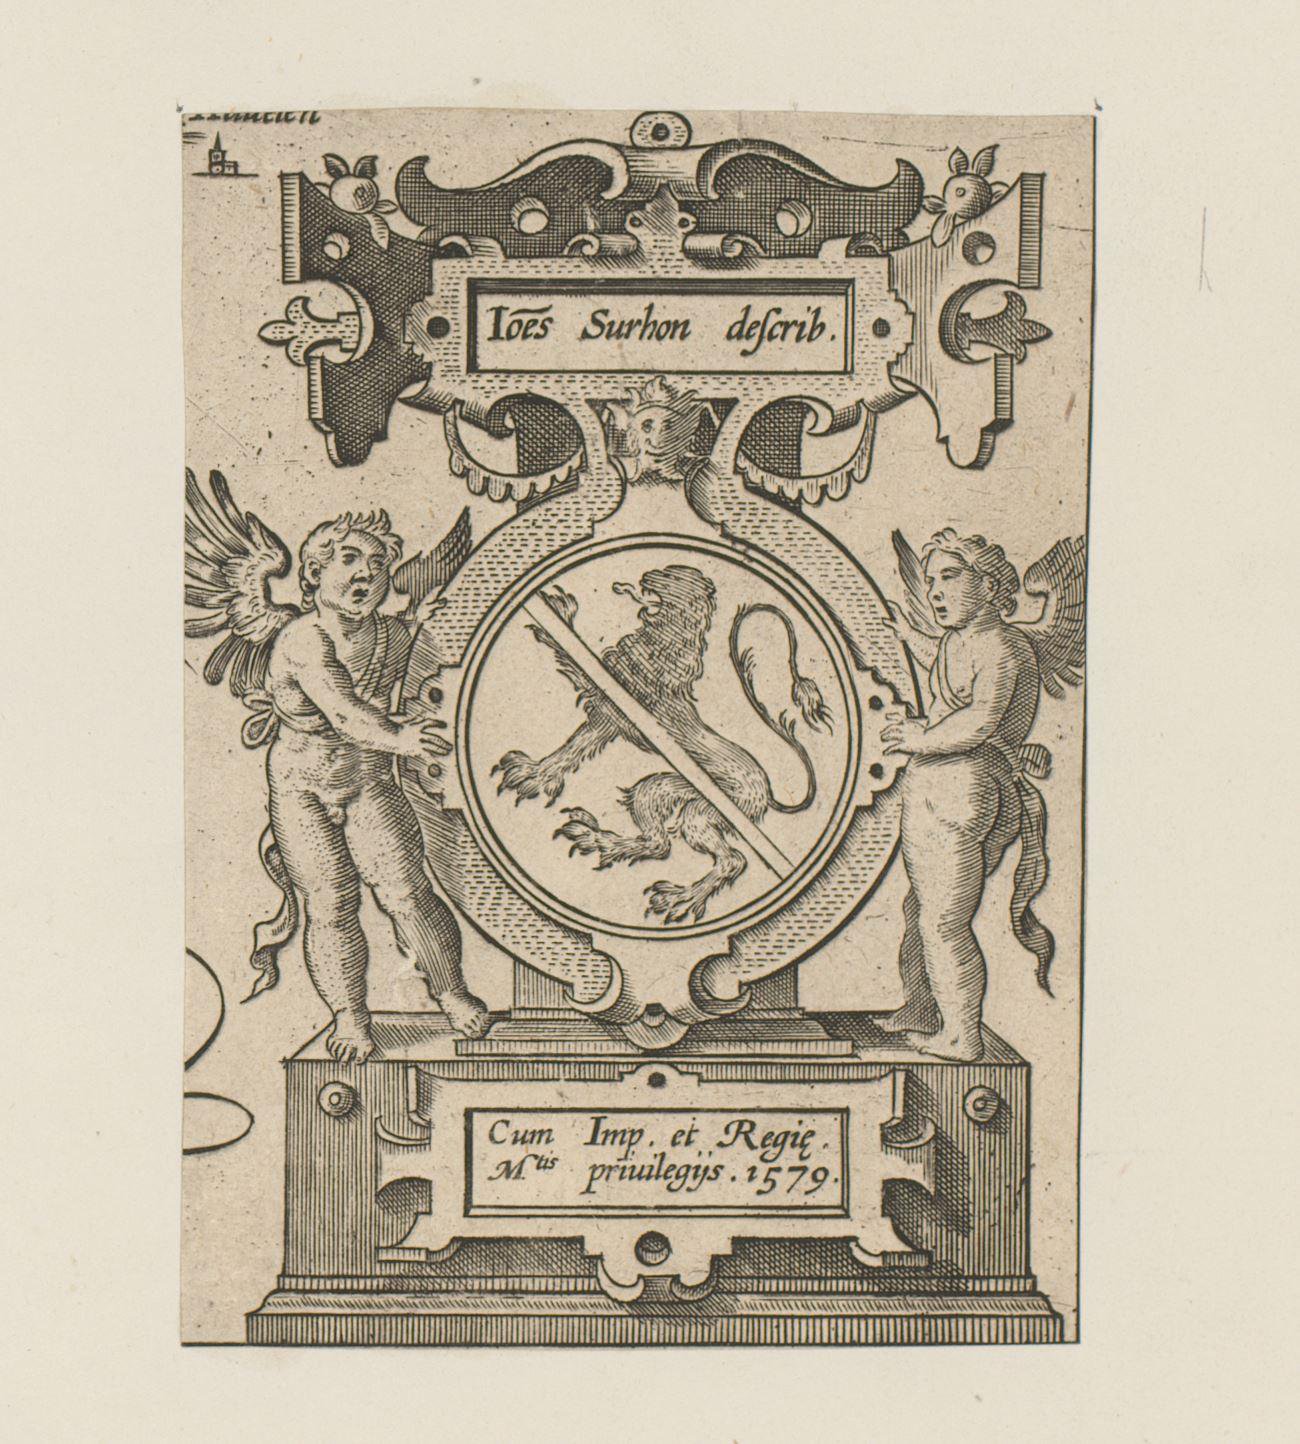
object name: ornament print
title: Theatrum Orbis Terrarum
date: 1579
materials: paper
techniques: engraving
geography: antwerp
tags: coat of arms (as symbol of the state, etc.), scrollwork, strapwork ~ ornament, ornament ~ cartouche, cupids: 'amores', 'amoretti', 'putti'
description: Rolwerkcartouche in drie delen. In het middelste ronde deel het wapen van het graafschap Namen, geflankeerd door twee putti. De cartouche is een fragment van een kaart van Namen. De prent maakt deel uit van een album.